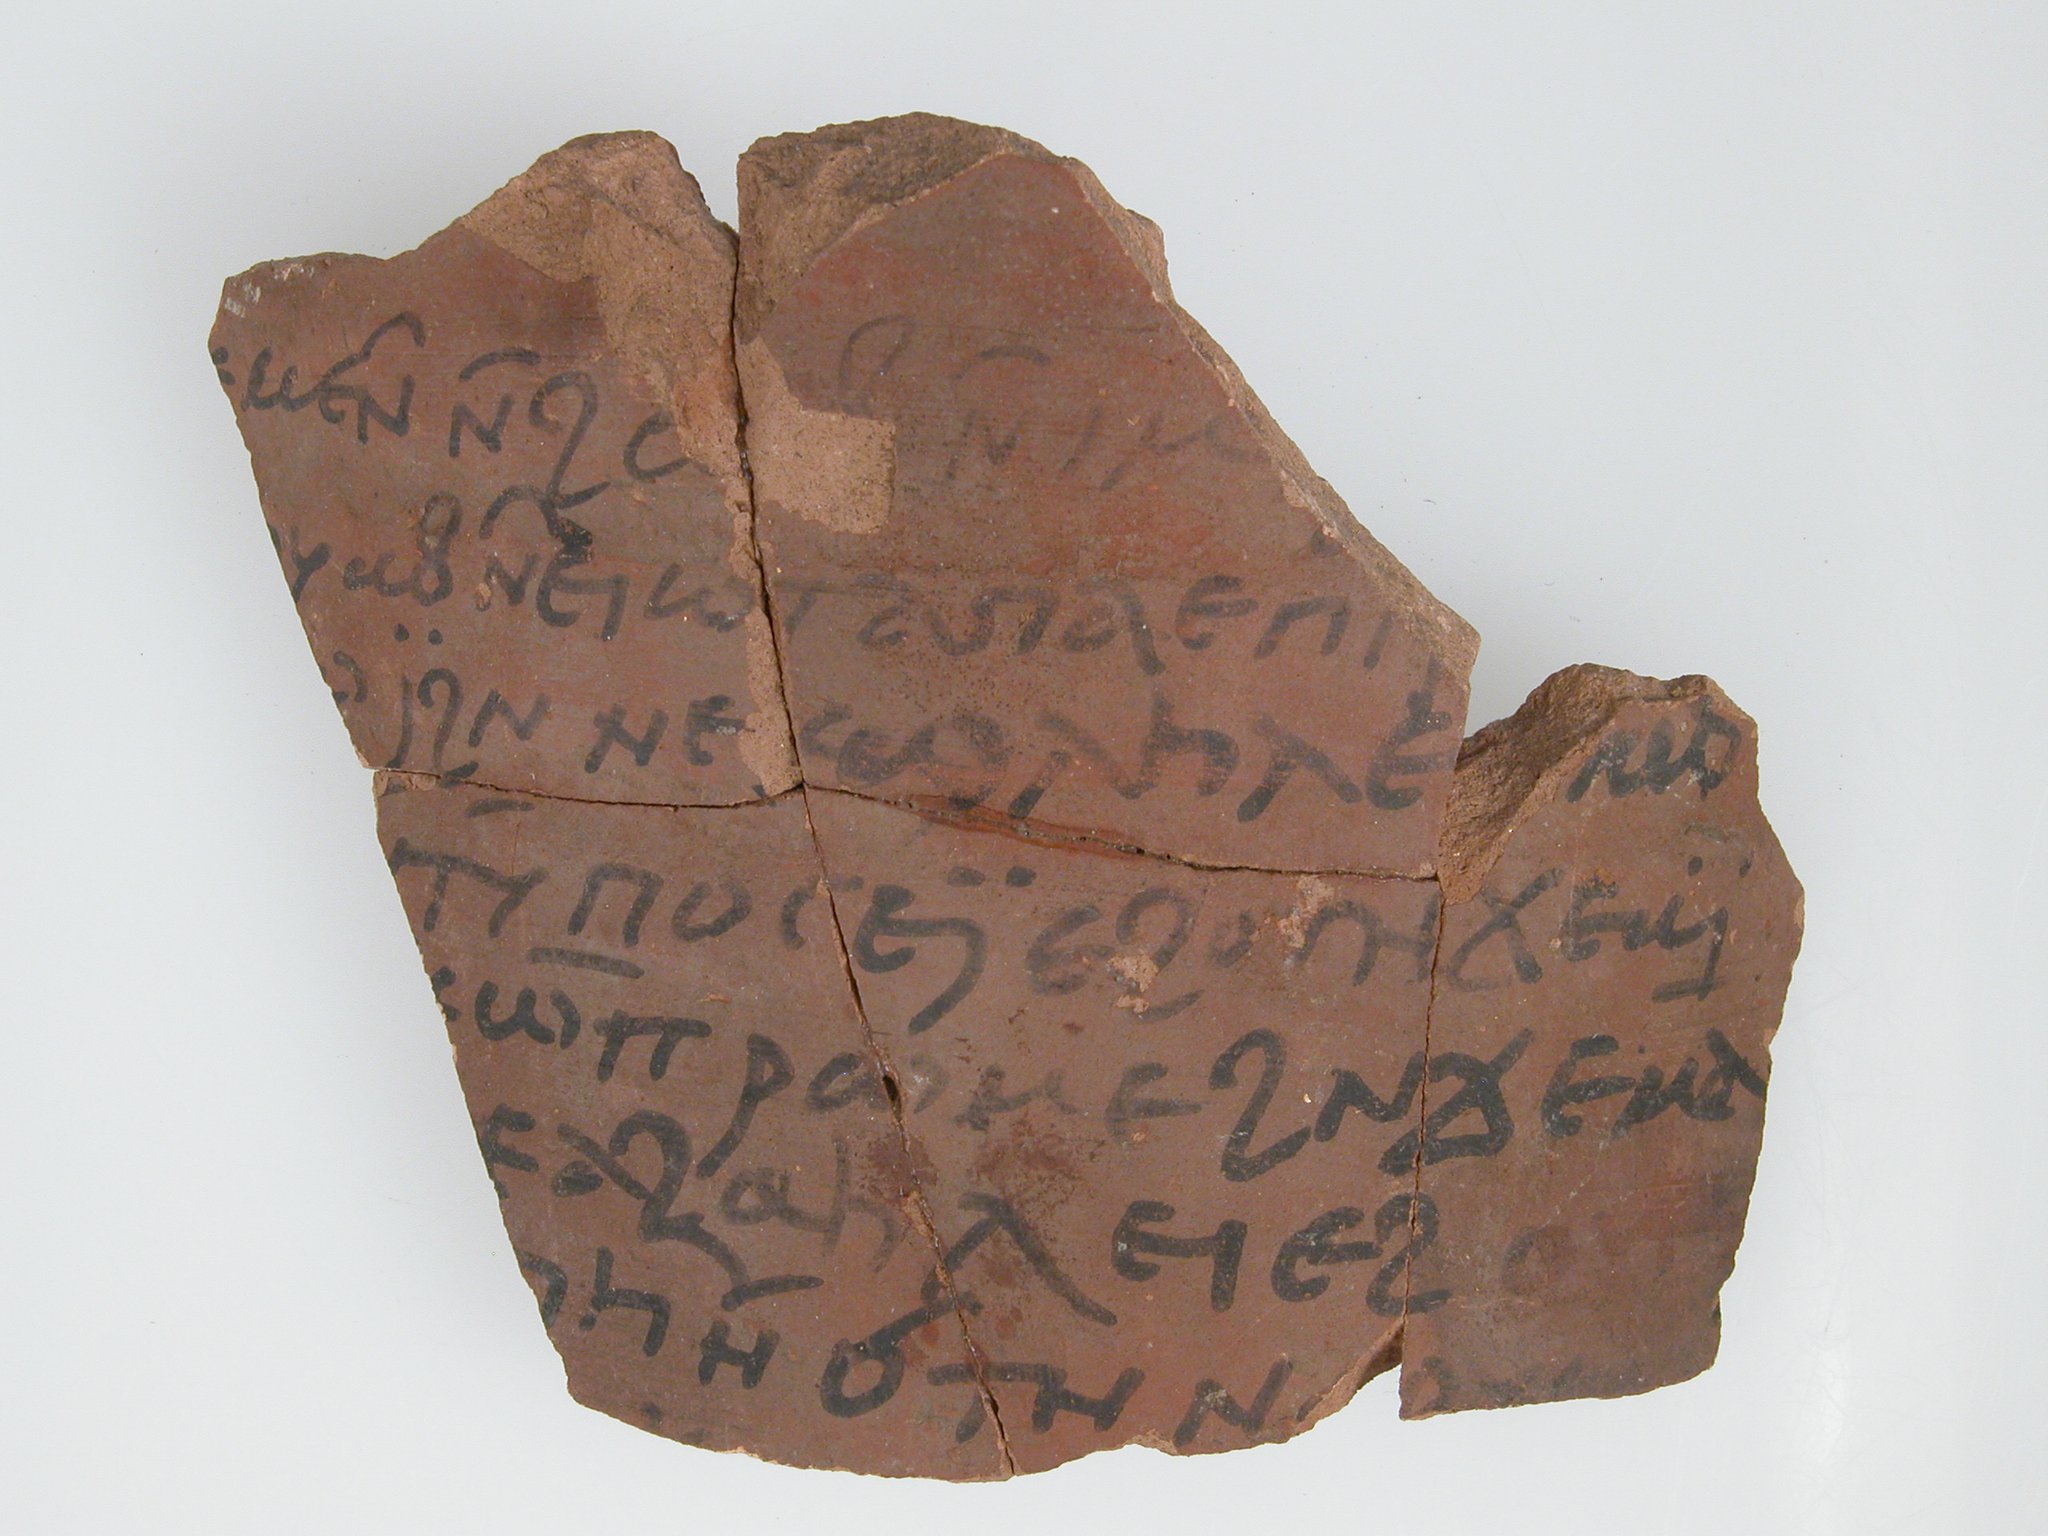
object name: ostrakon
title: Ostrakon with a Letter from Paternoute to Epiphanius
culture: coptic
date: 600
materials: ink, pottery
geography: egypt